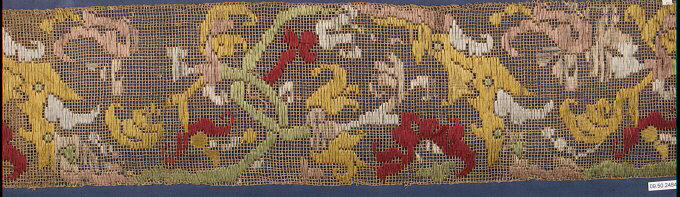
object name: fragment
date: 1601-1700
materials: silk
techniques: embroidery